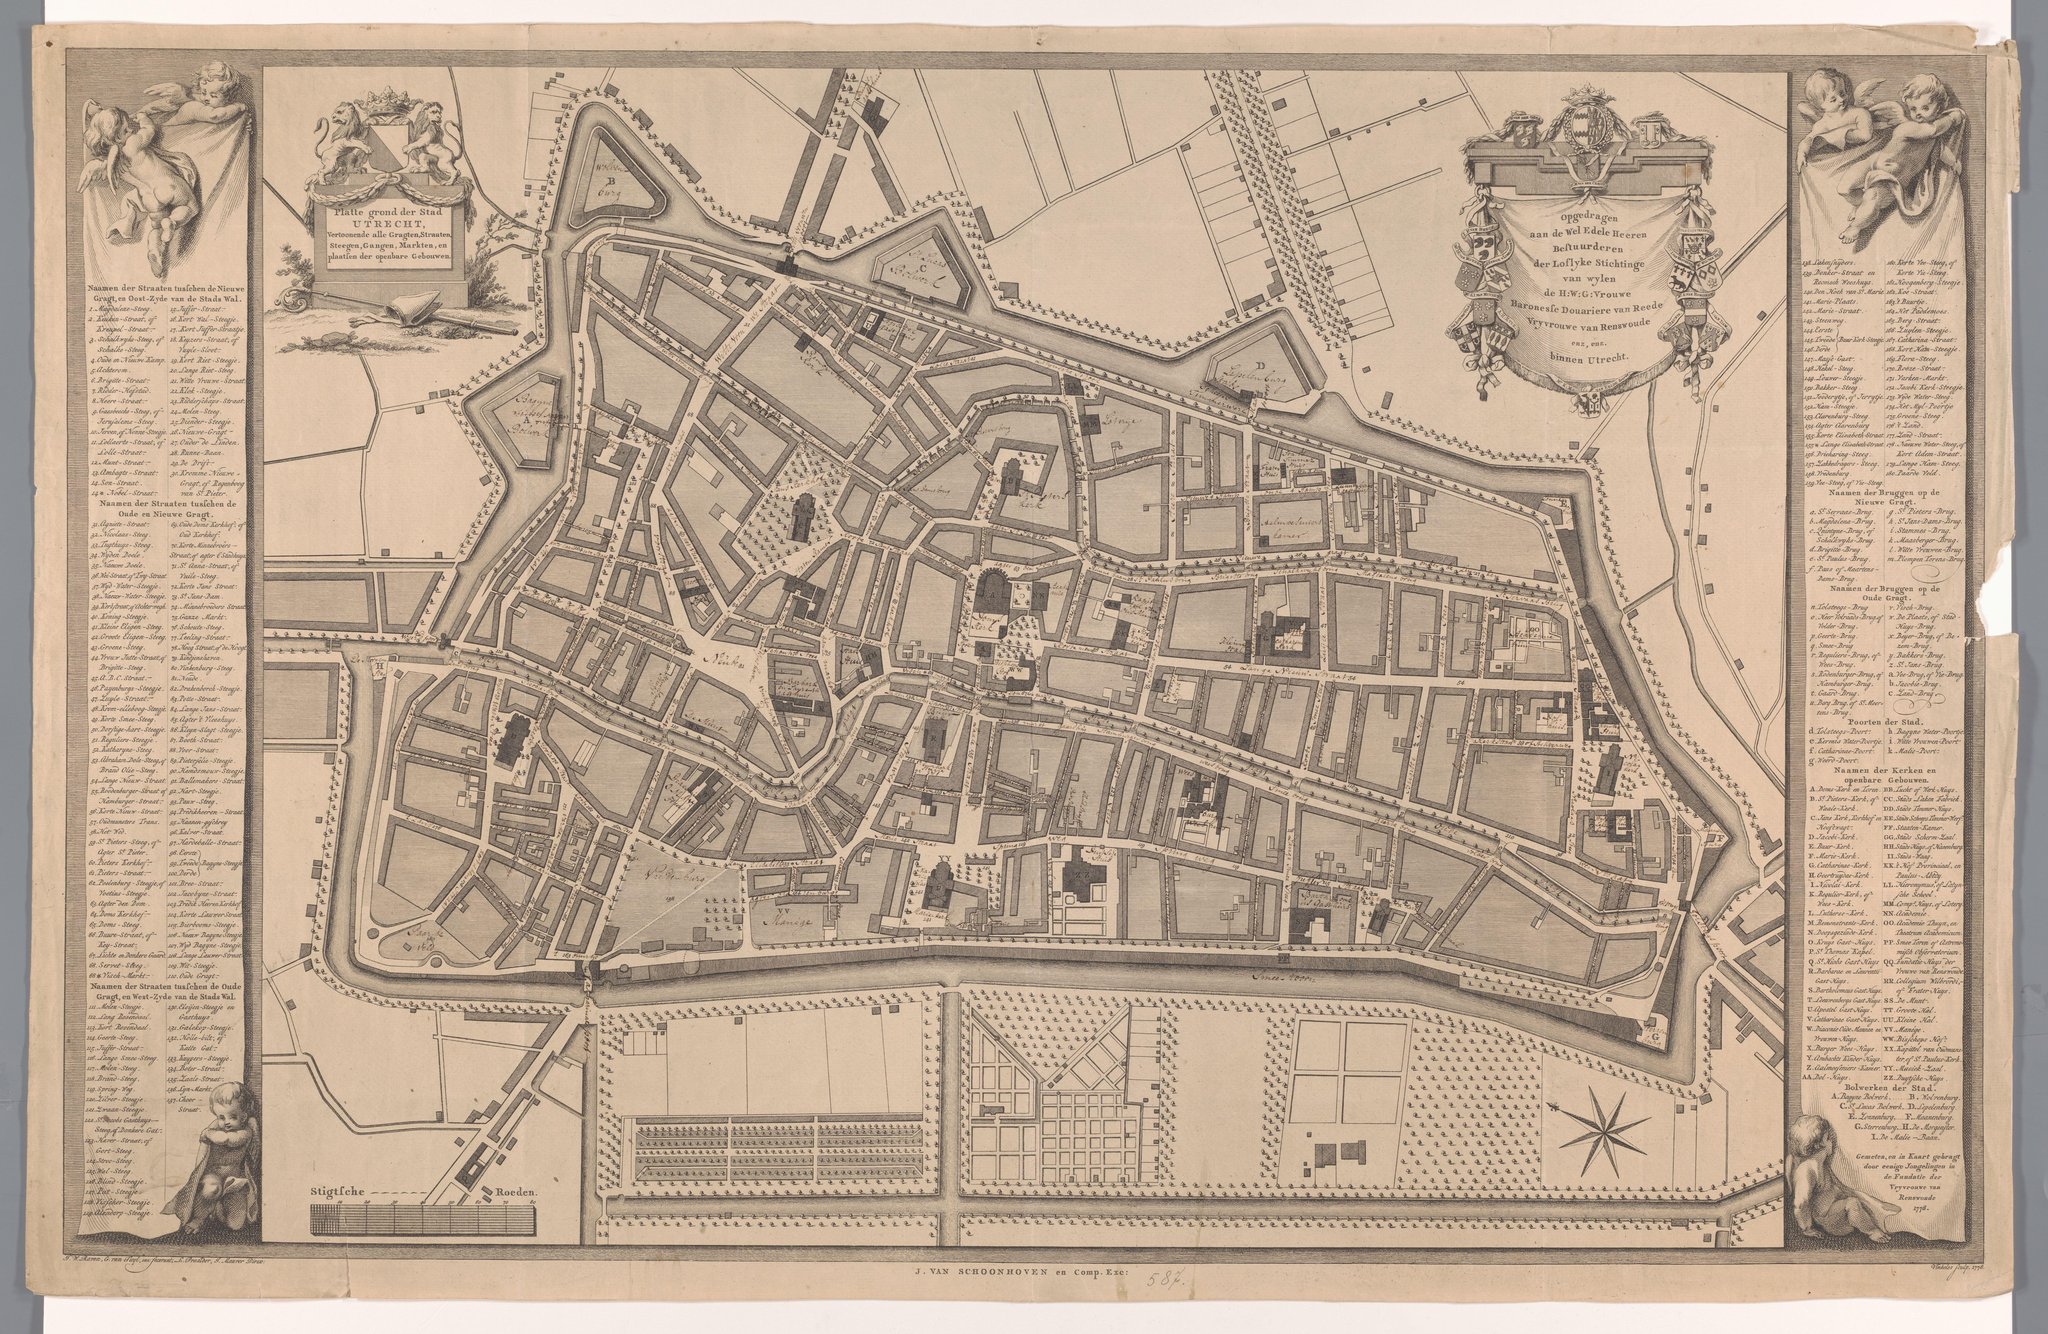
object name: area plan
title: Plattegrond van Utrecht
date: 1778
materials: ink, paper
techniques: etching, pen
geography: amsterdam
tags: maps of cities, utrecht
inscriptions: collector's mark: Lugt 2228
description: Rechtsboven een cartouche met opdracht aan de bestuurders van de stichting van de barones Douariere van Reede, vrijvrouwe van Renswoude.